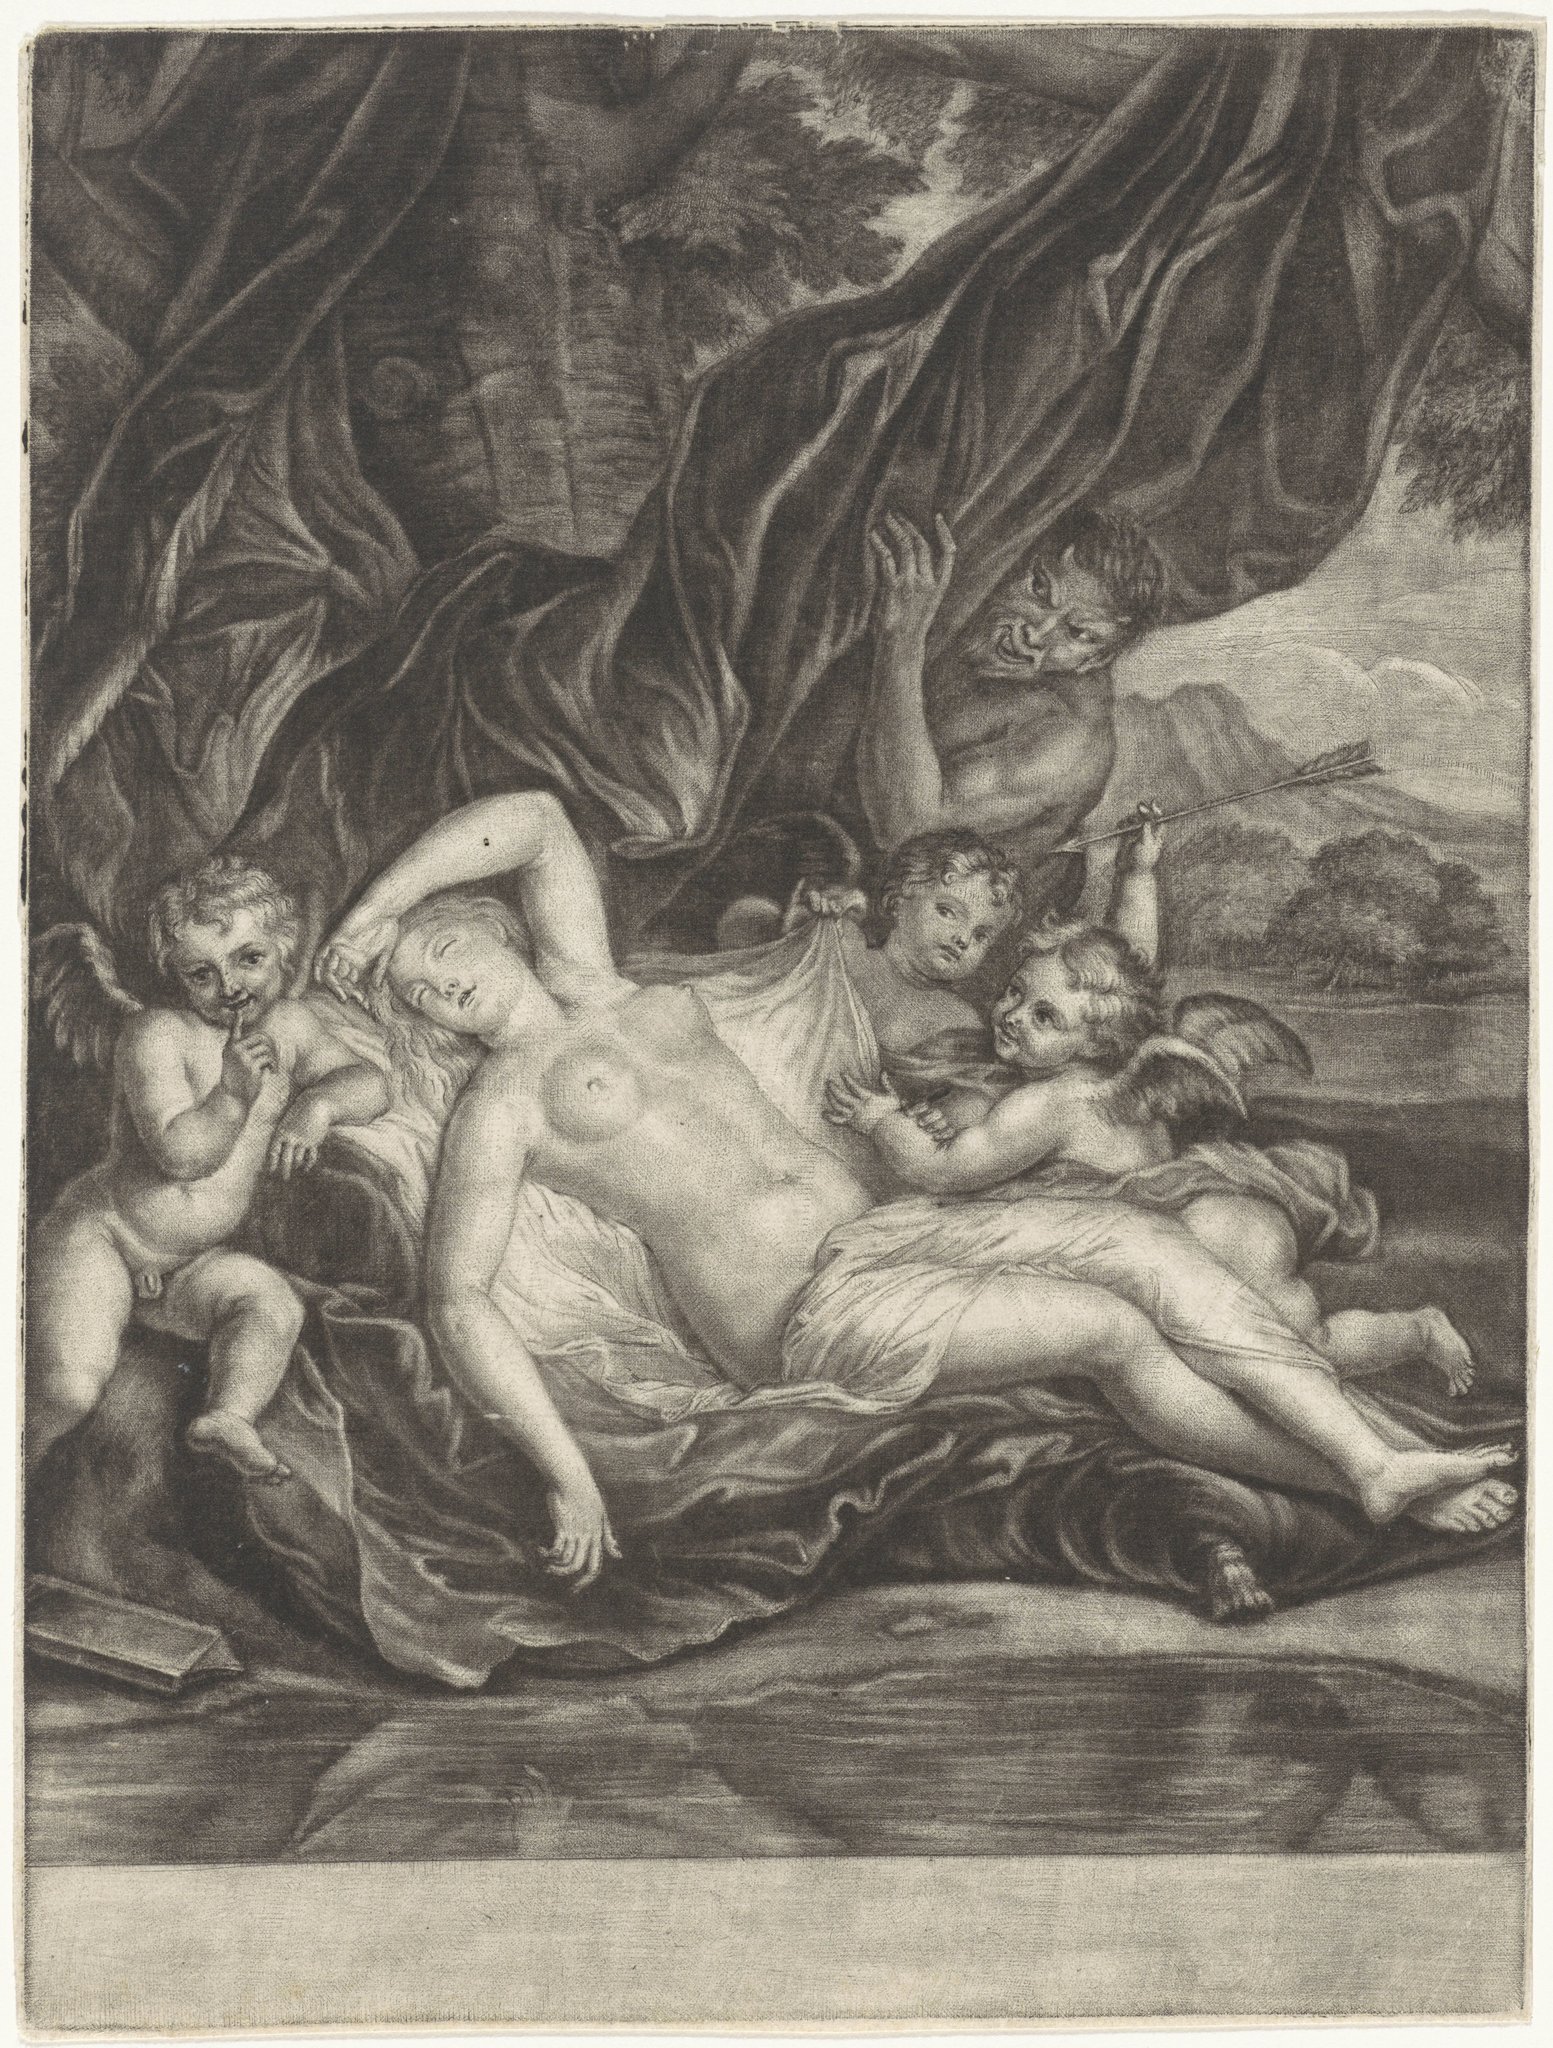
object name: print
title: Sater bespiedt een slapende nimf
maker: Anonymous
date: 1650-1800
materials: paper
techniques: mezzotint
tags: satyr(s) spying upon, sleeping; unconsciousness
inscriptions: collector's mark: Lugt 2228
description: Een nimf ligt onder een boom te slapen en wordt bespied door een sater. Amor staat op het punt om haar hart te doorboren met een pijl.